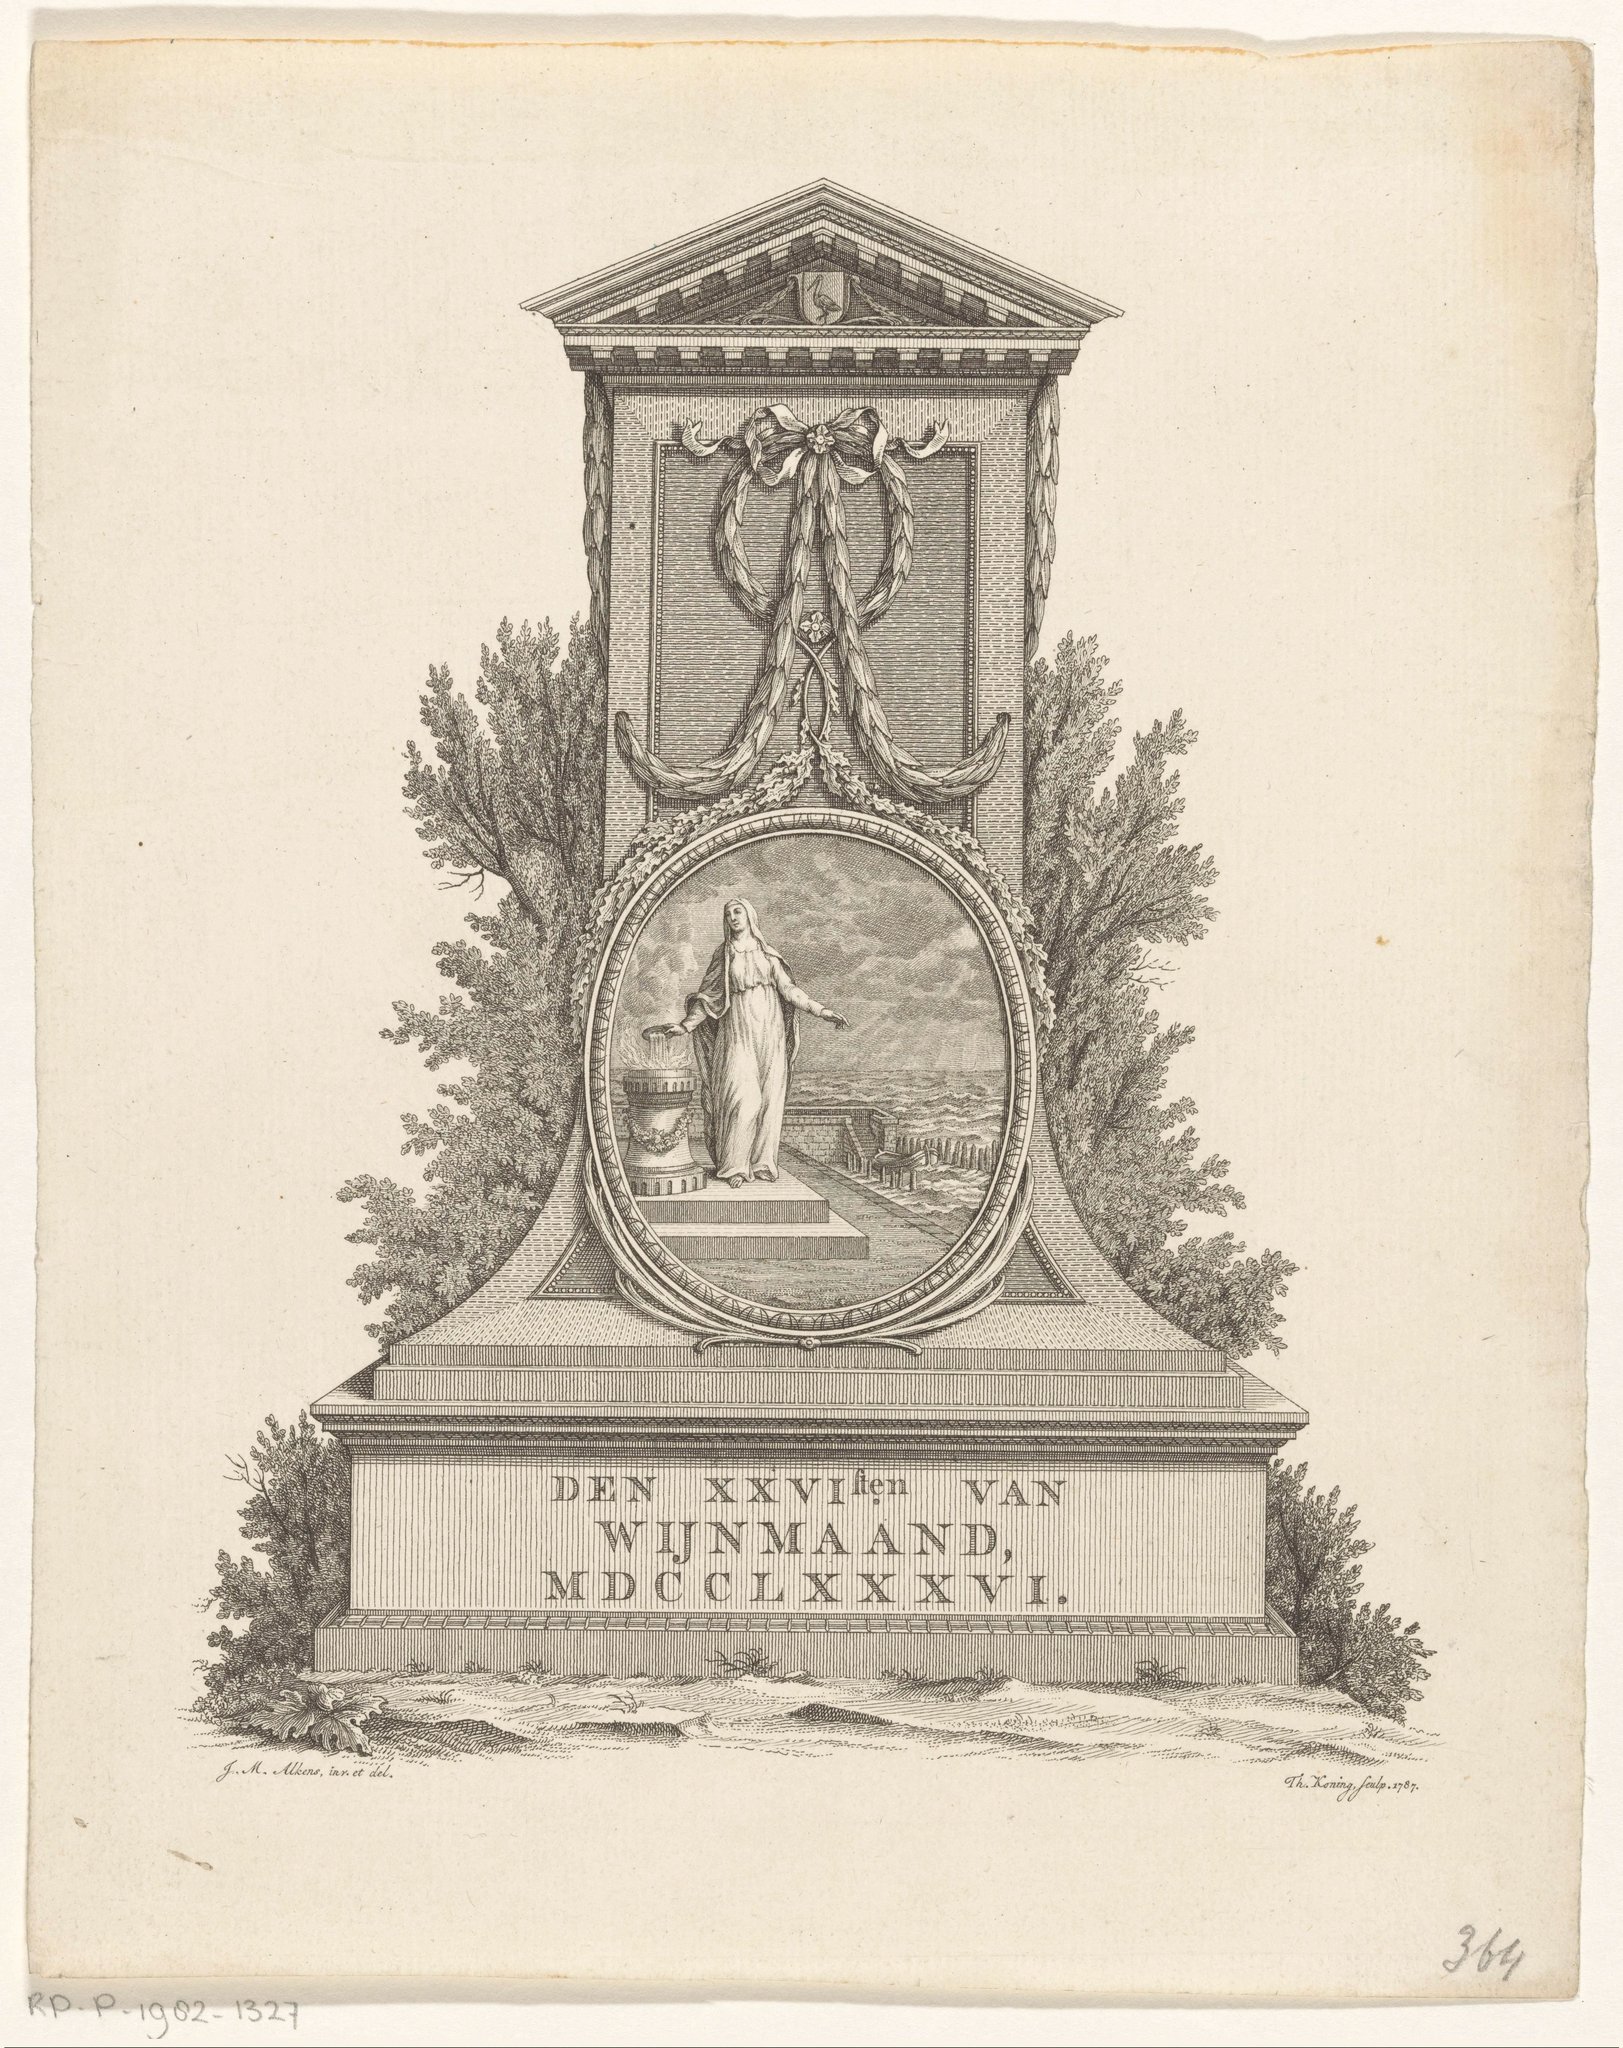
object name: print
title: Monument met medaillon van vrouw bij altaar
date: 1787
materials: paper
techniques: engraving, etching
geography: amsterdam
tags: altar ~ non-christian religions, ornament ~ medallion, landscape with monument, standing figure - aa - female human figure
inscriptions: collector's mark: Lugt 2228, collector's mark: Lugt 2760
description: Een monument in een landschap met in het midden een ovaal medaillon. Op het medaillon staat een vrouw bij een brandend altaar. In de achtergrond ligt een boot op zee.